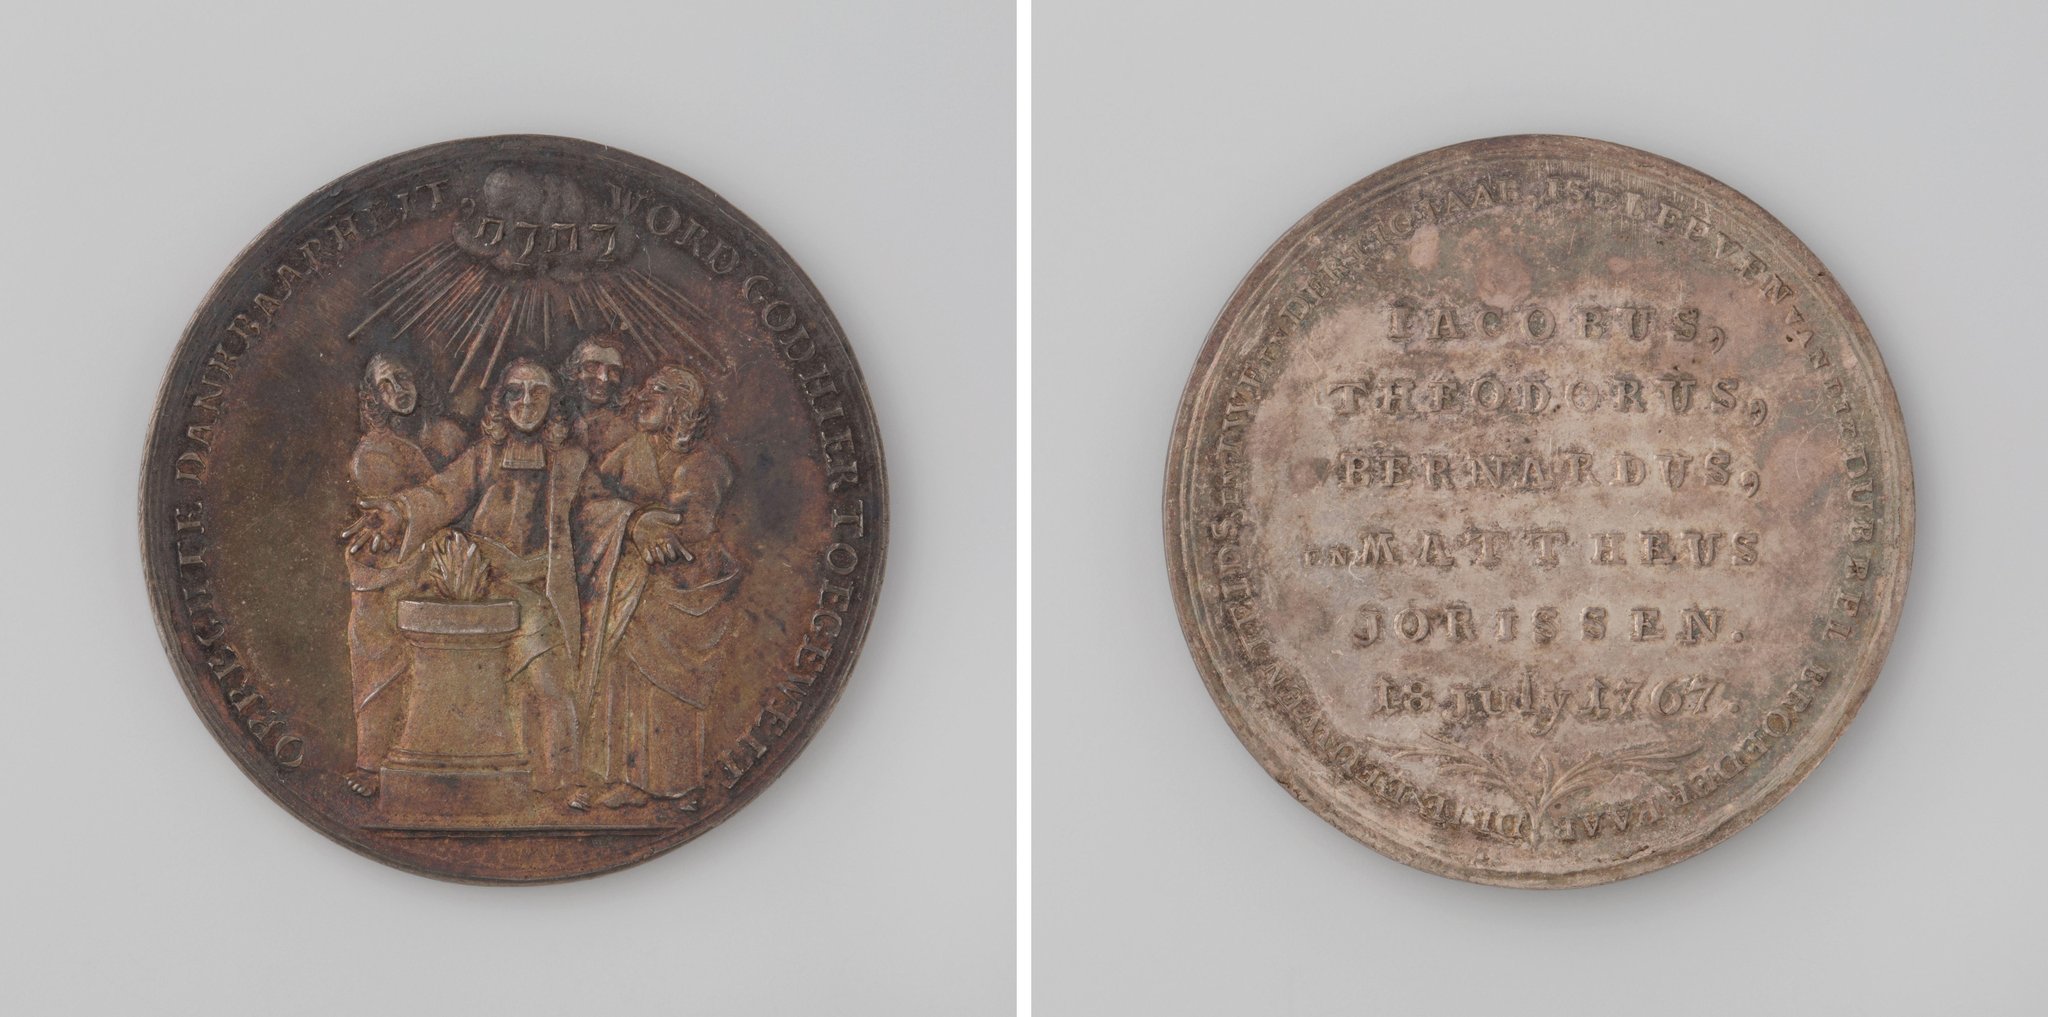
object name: verjaardagspenning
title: Vier gebroeders Jorissen, samen 332 jaar oud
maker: carel frederik konsé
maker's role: painter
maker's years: 1736-1786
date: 1767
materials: silver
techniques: striking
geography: netherlands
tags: jacobus jorissen, theodorus jorissen, bernardus jorissen, mattheus jorissen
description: Zilveren penning. Voorzijde: vier mannen staande bij brandend altaar, beschenen door stralende wolk, waarin naam Jehovah in Hebrweeuws geschreven staat binnen omschrift. Keerzijde: opschrift boven twee bladertakken binnen omschrift